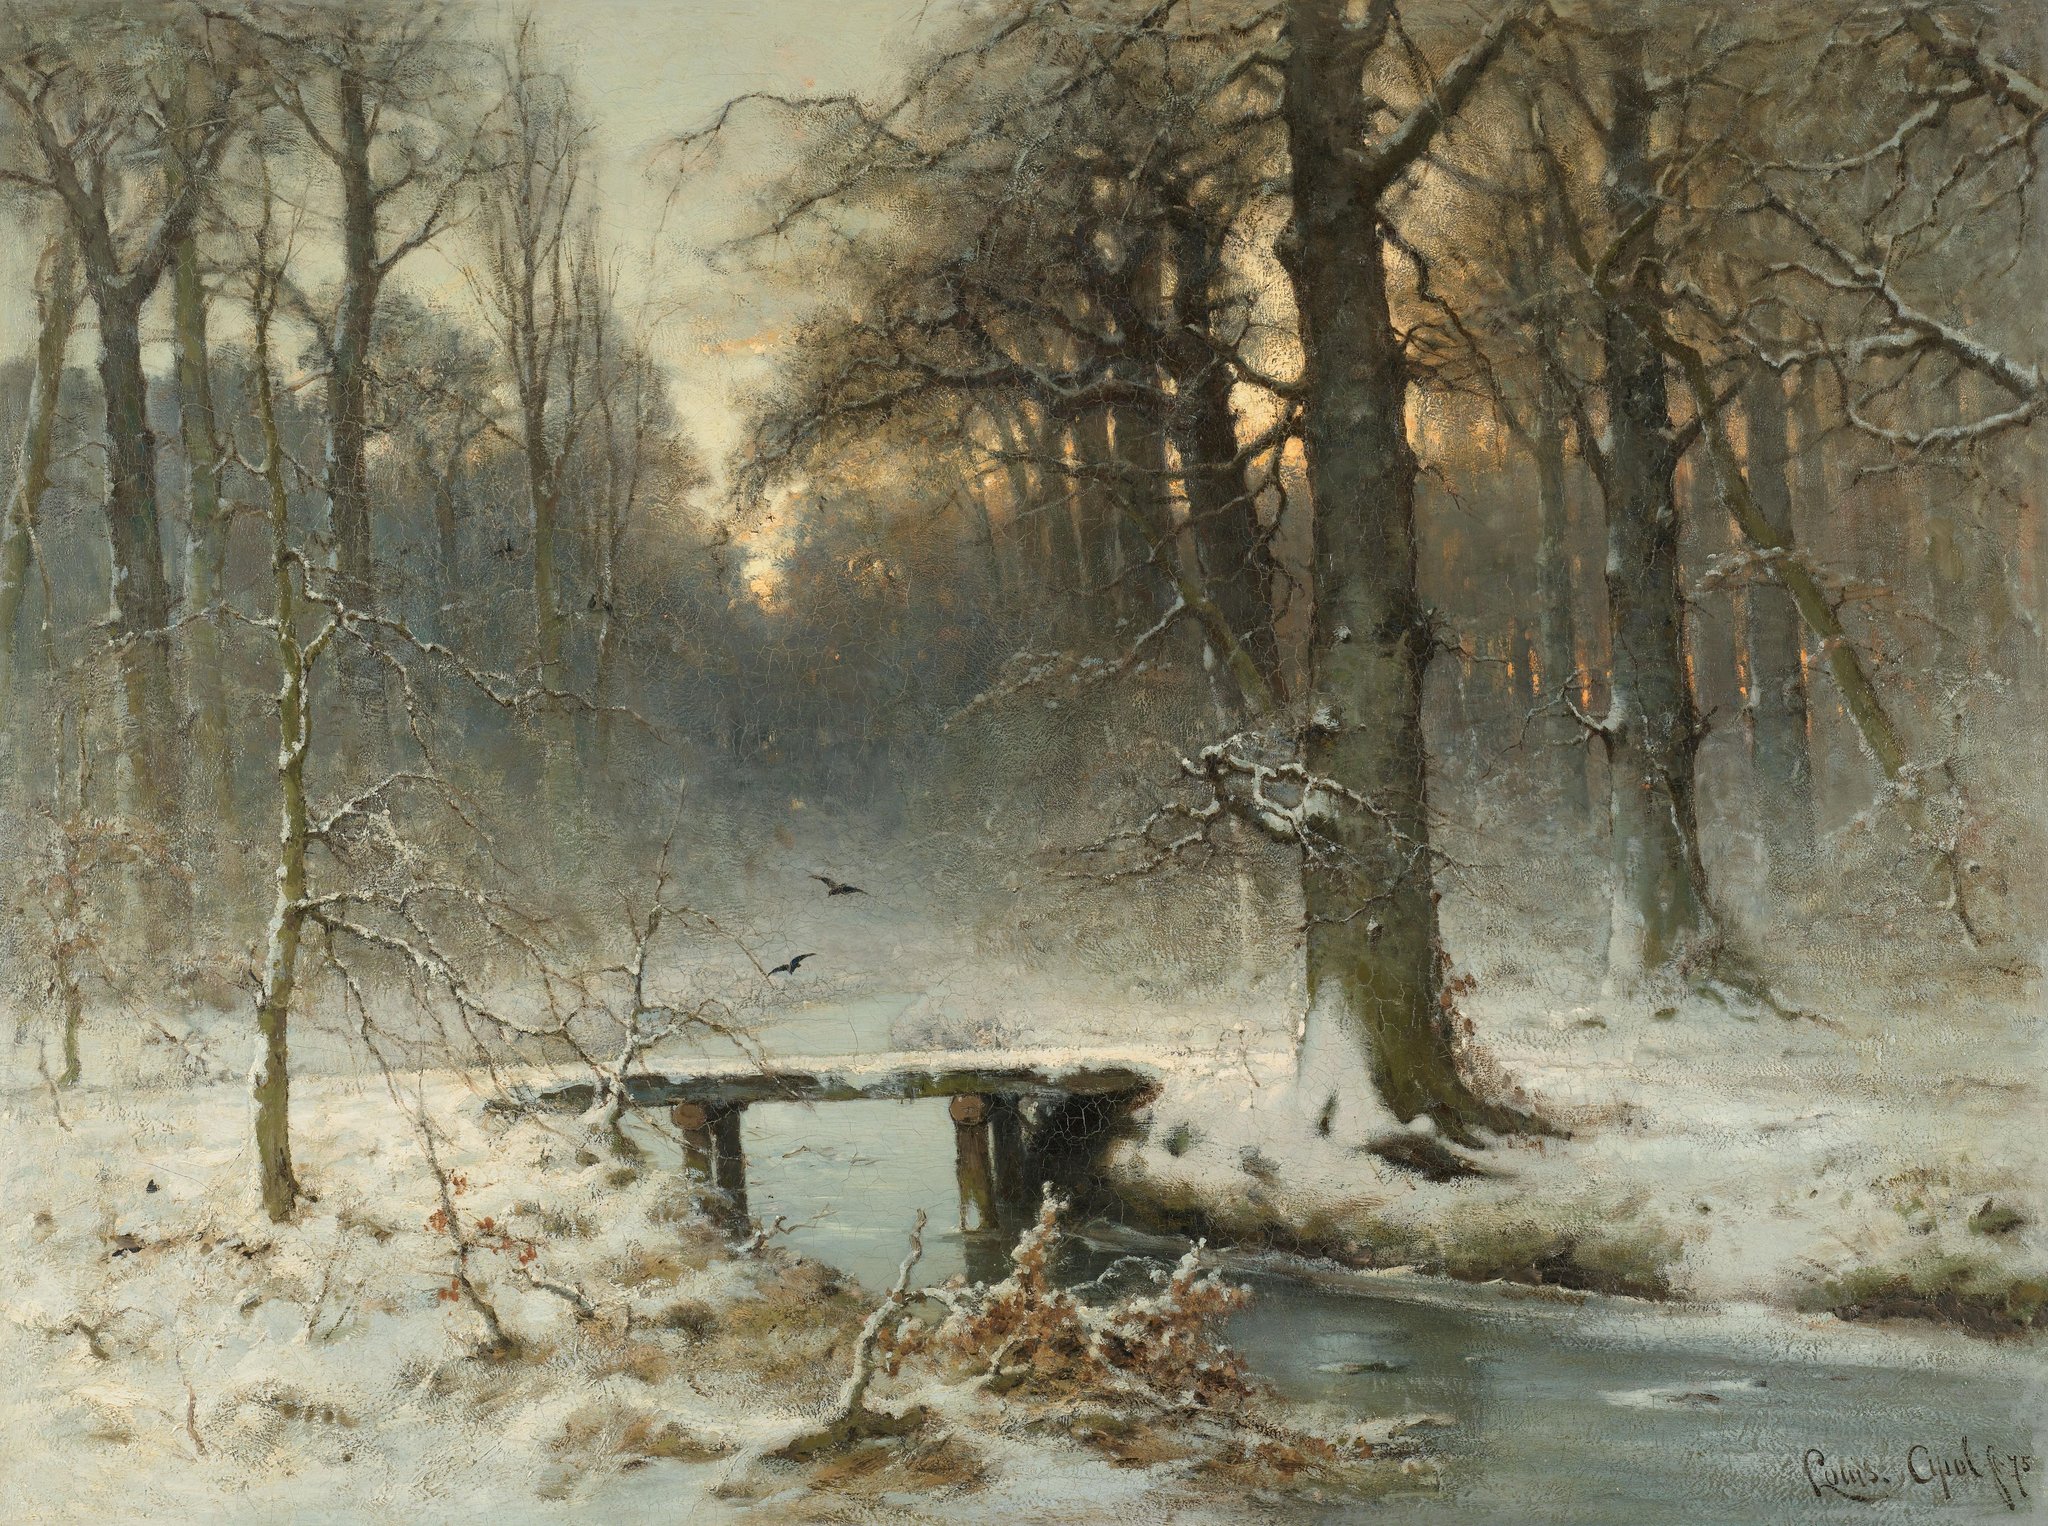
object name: painting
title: A January Evening in the Woods of The Hague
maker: louis apol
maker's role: draughtsman, painter, print maker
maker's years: 1850-1936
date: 1875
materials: canvas, oil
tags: forest, wood, winter landscape; landscape symbolizing winter (the four seasons of the year)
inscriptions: signature and date: ‘Louis Apol ft 75’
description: Gezicht in het Haagse Bos tijdens de winter. In het midden een houten bruggetje over een slootje.